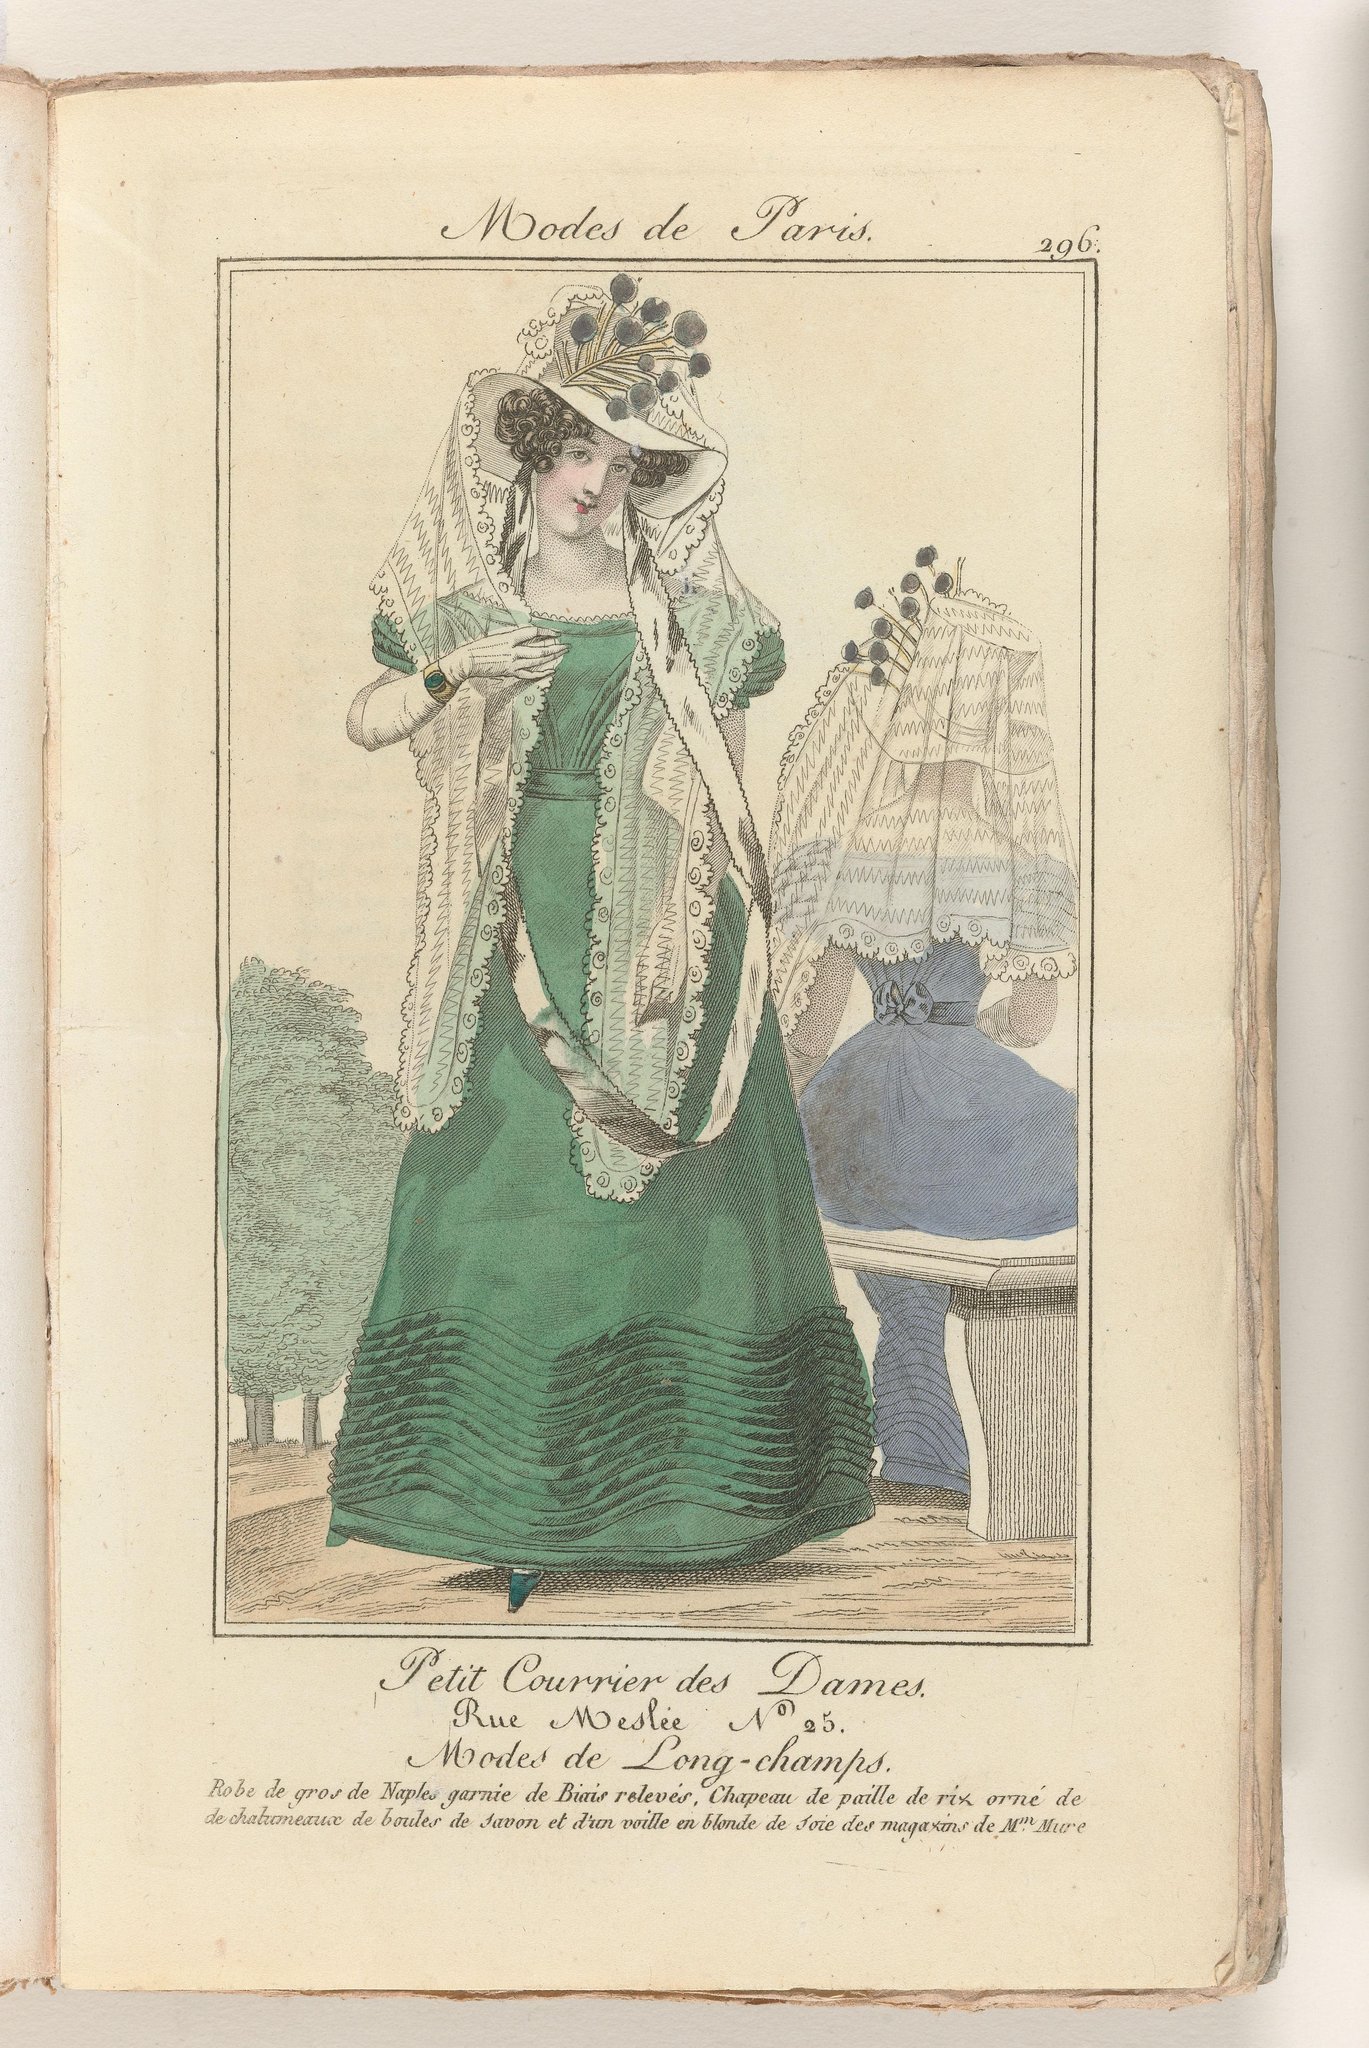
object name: magazine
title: Petit Courrier des Dames, ou Nouveau Journal des Modes, des Théatres, de la Litterature et des Arts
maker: Anonymous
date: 1825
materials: paper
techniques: engraving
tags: fashion plates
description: Prent uit het modetijdschrift Petit Courrier des Dames (1821-1868).